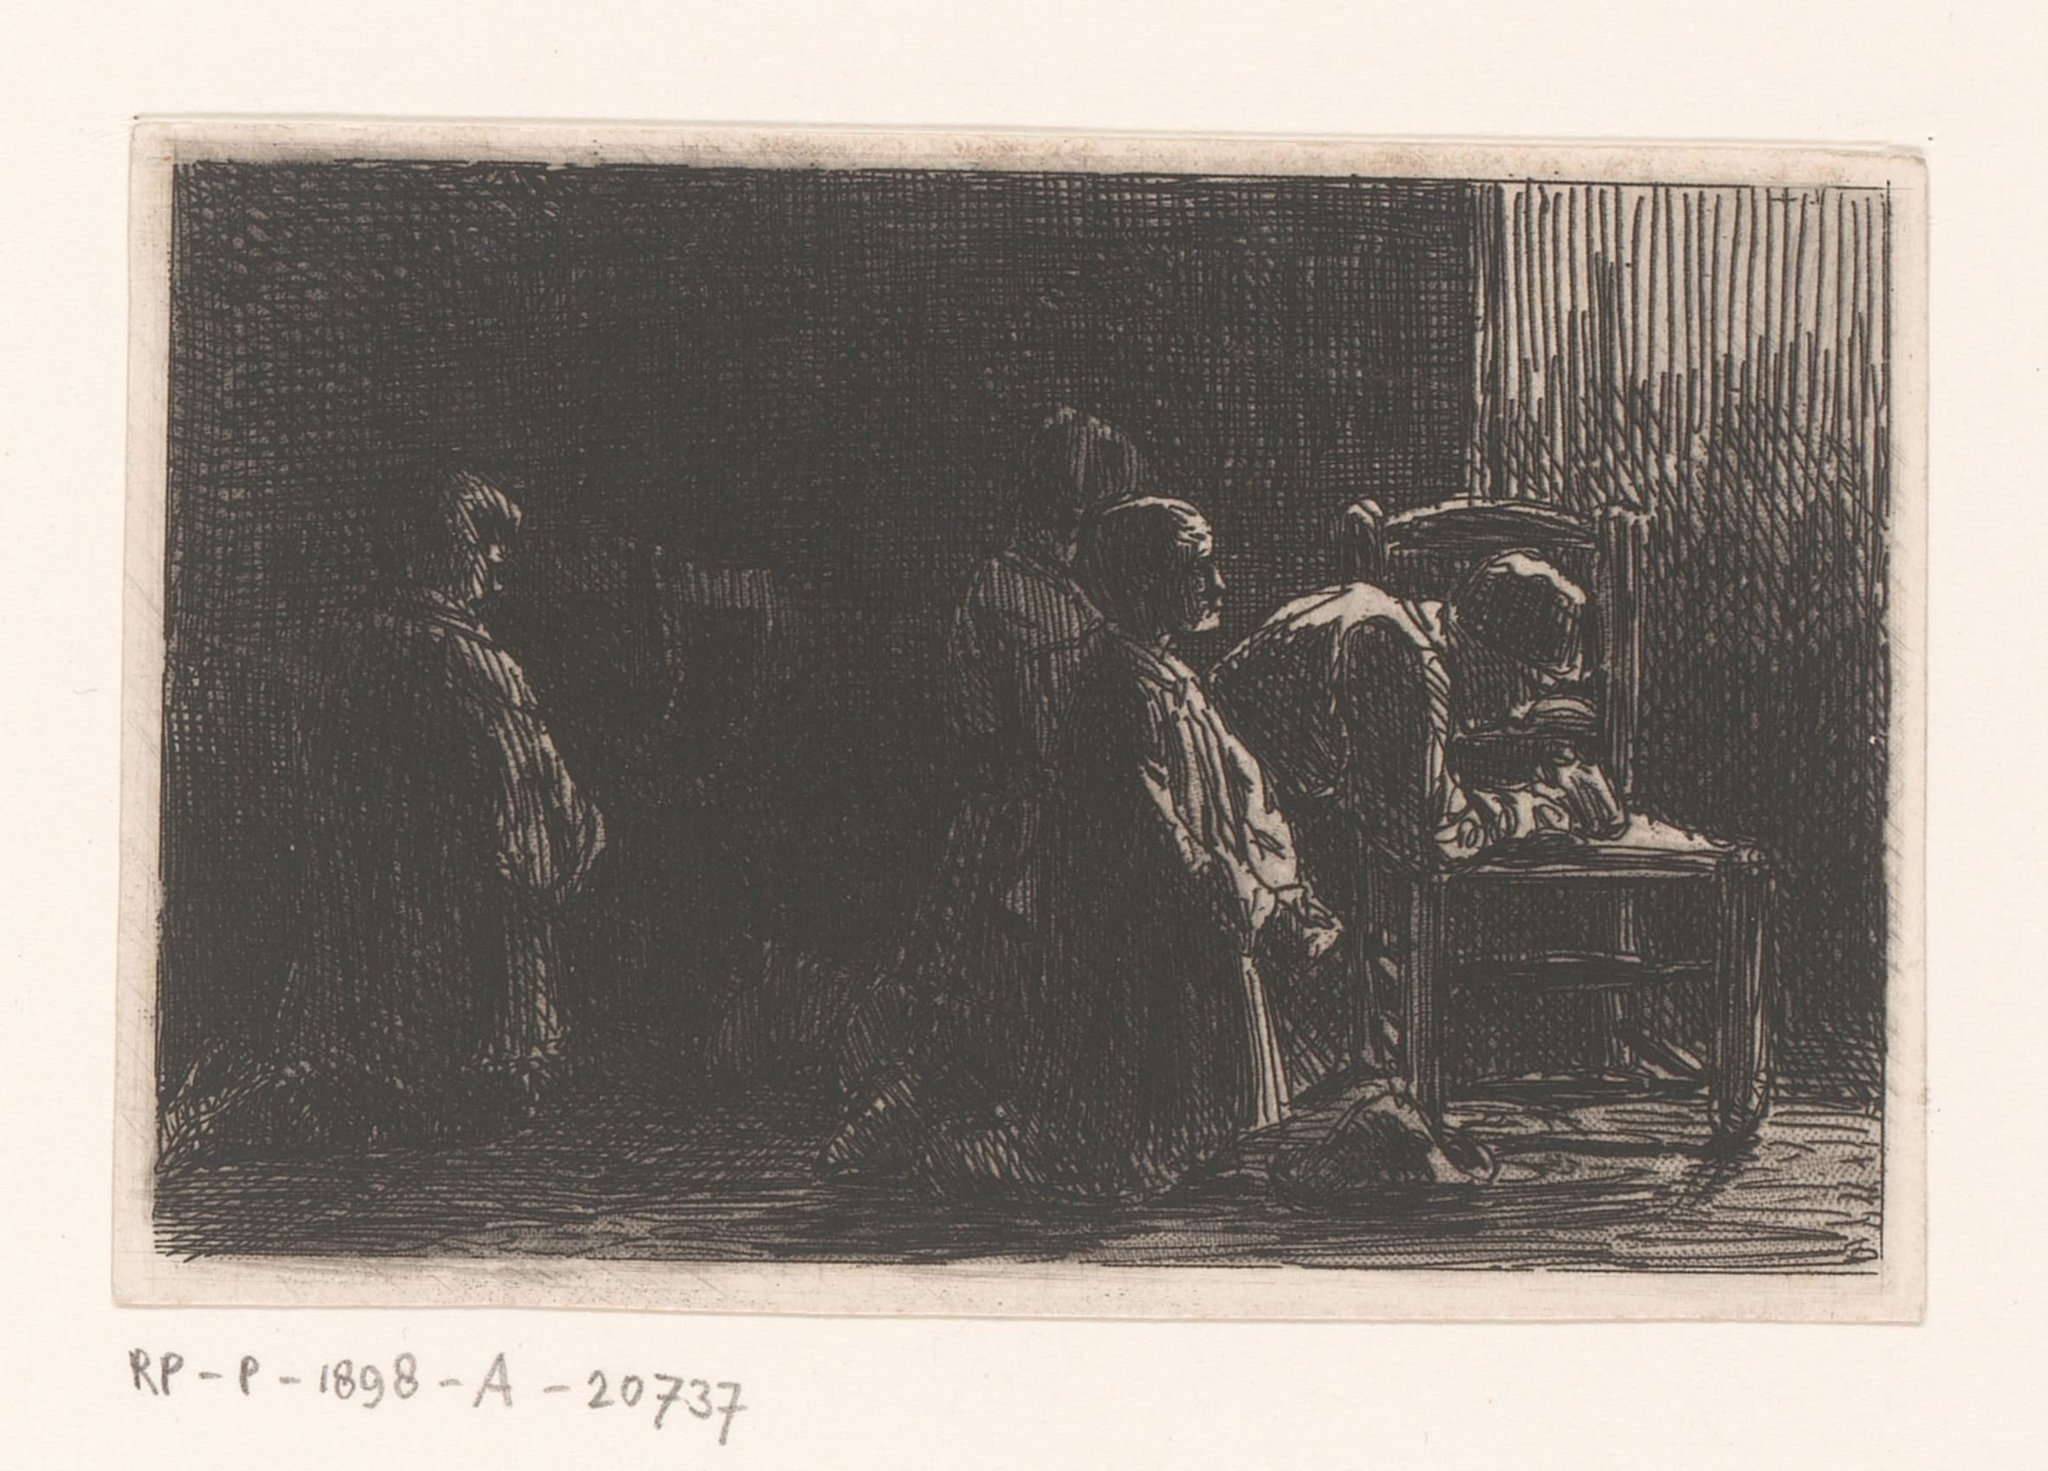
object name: print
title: Biddende figuren voor een stoel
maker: charles emile jacque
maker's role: draughtsman, painter, print maker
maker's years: 1813-1894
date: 1843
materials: paper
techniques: etching, roulette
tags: family group, especially parents with their child(ren), (private) prayer; 'oratione', 'preghiere', 'preghiere a dio' (ripa)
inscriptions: collector's mark: Lugt 964